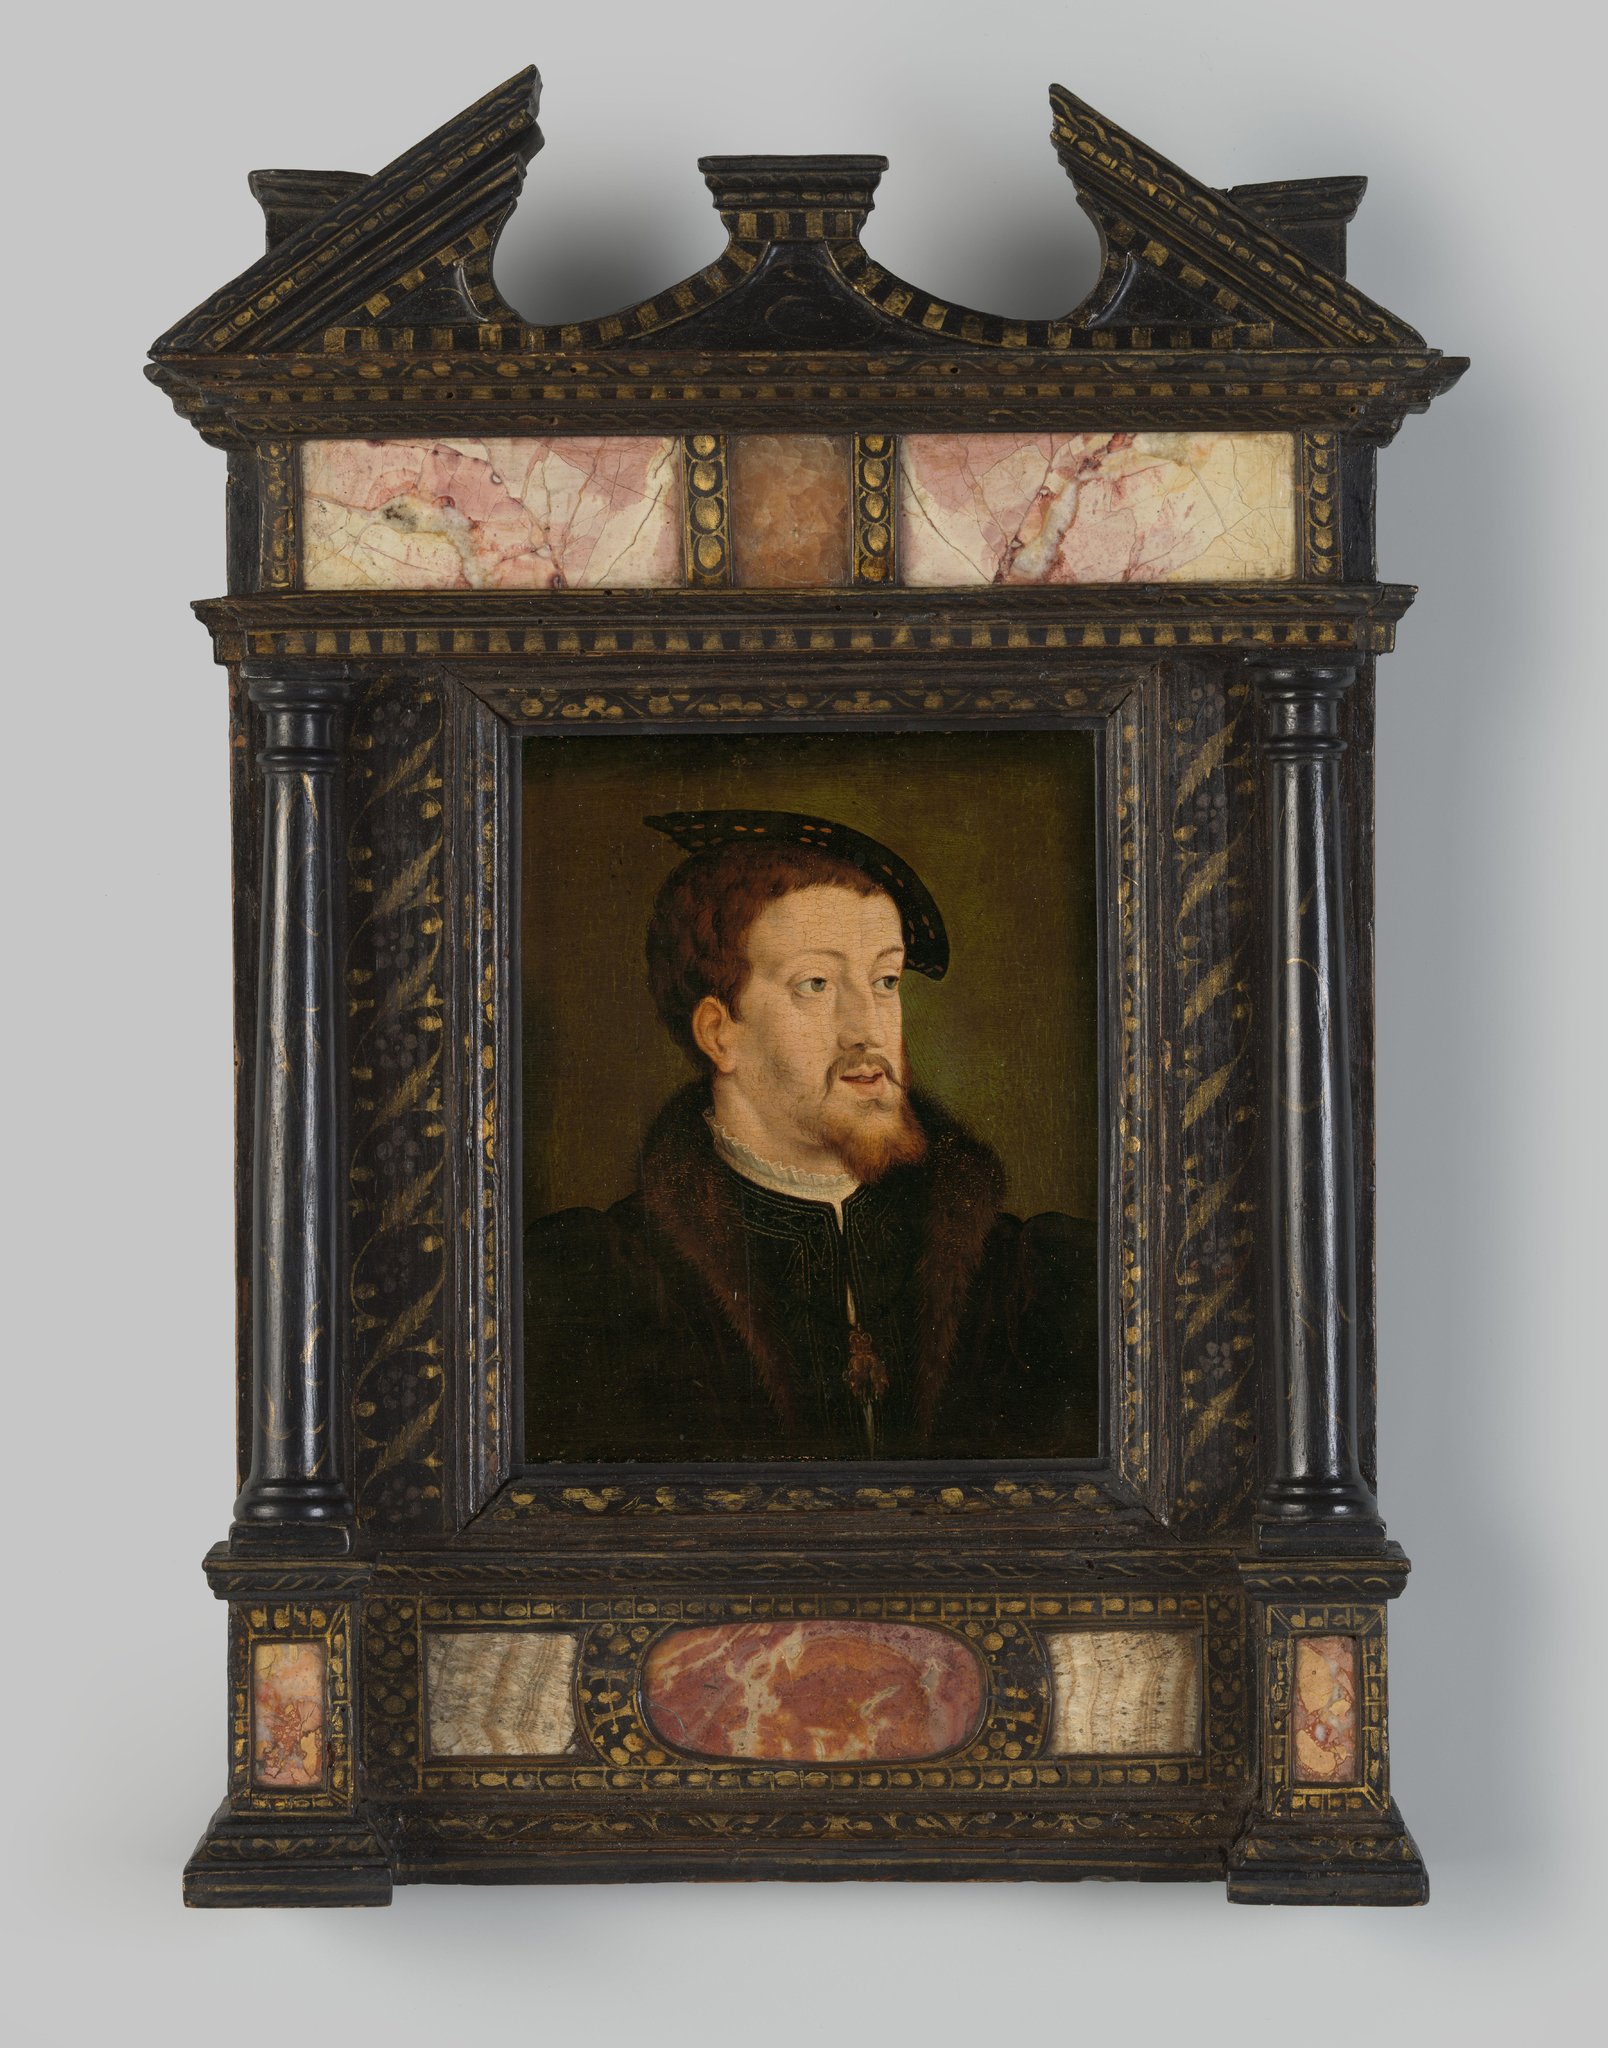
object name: painting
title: Portrait of Charles V, Holy Roman Emperor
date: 1530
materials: oil, panel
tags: ghent, charles v (holy roman emperor and king of spain), historical persons, emperor, knighthood order of the golden fleece - insignia of a knighthood order, e.g.: badge, chain (with name of order)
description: Karel V, 1500-1558. Copie naar een verloren portret door J. C. Vermeyen. Omstreeks 1525. Karel V aanvaardde als 15-jarige het bewind over de Nederlanden, werd in 1516 koning van Spanje en erfde in 1519 alle Habsburgse bezittingen en werd tot keizer van Duitsland gekroond. Zijn titulatuur noemt hem ook: 'koning van de Indische eilanden, alsmede van het vaste land aan gene zijde van de Oceaan en heer van Azië en Afrika'.